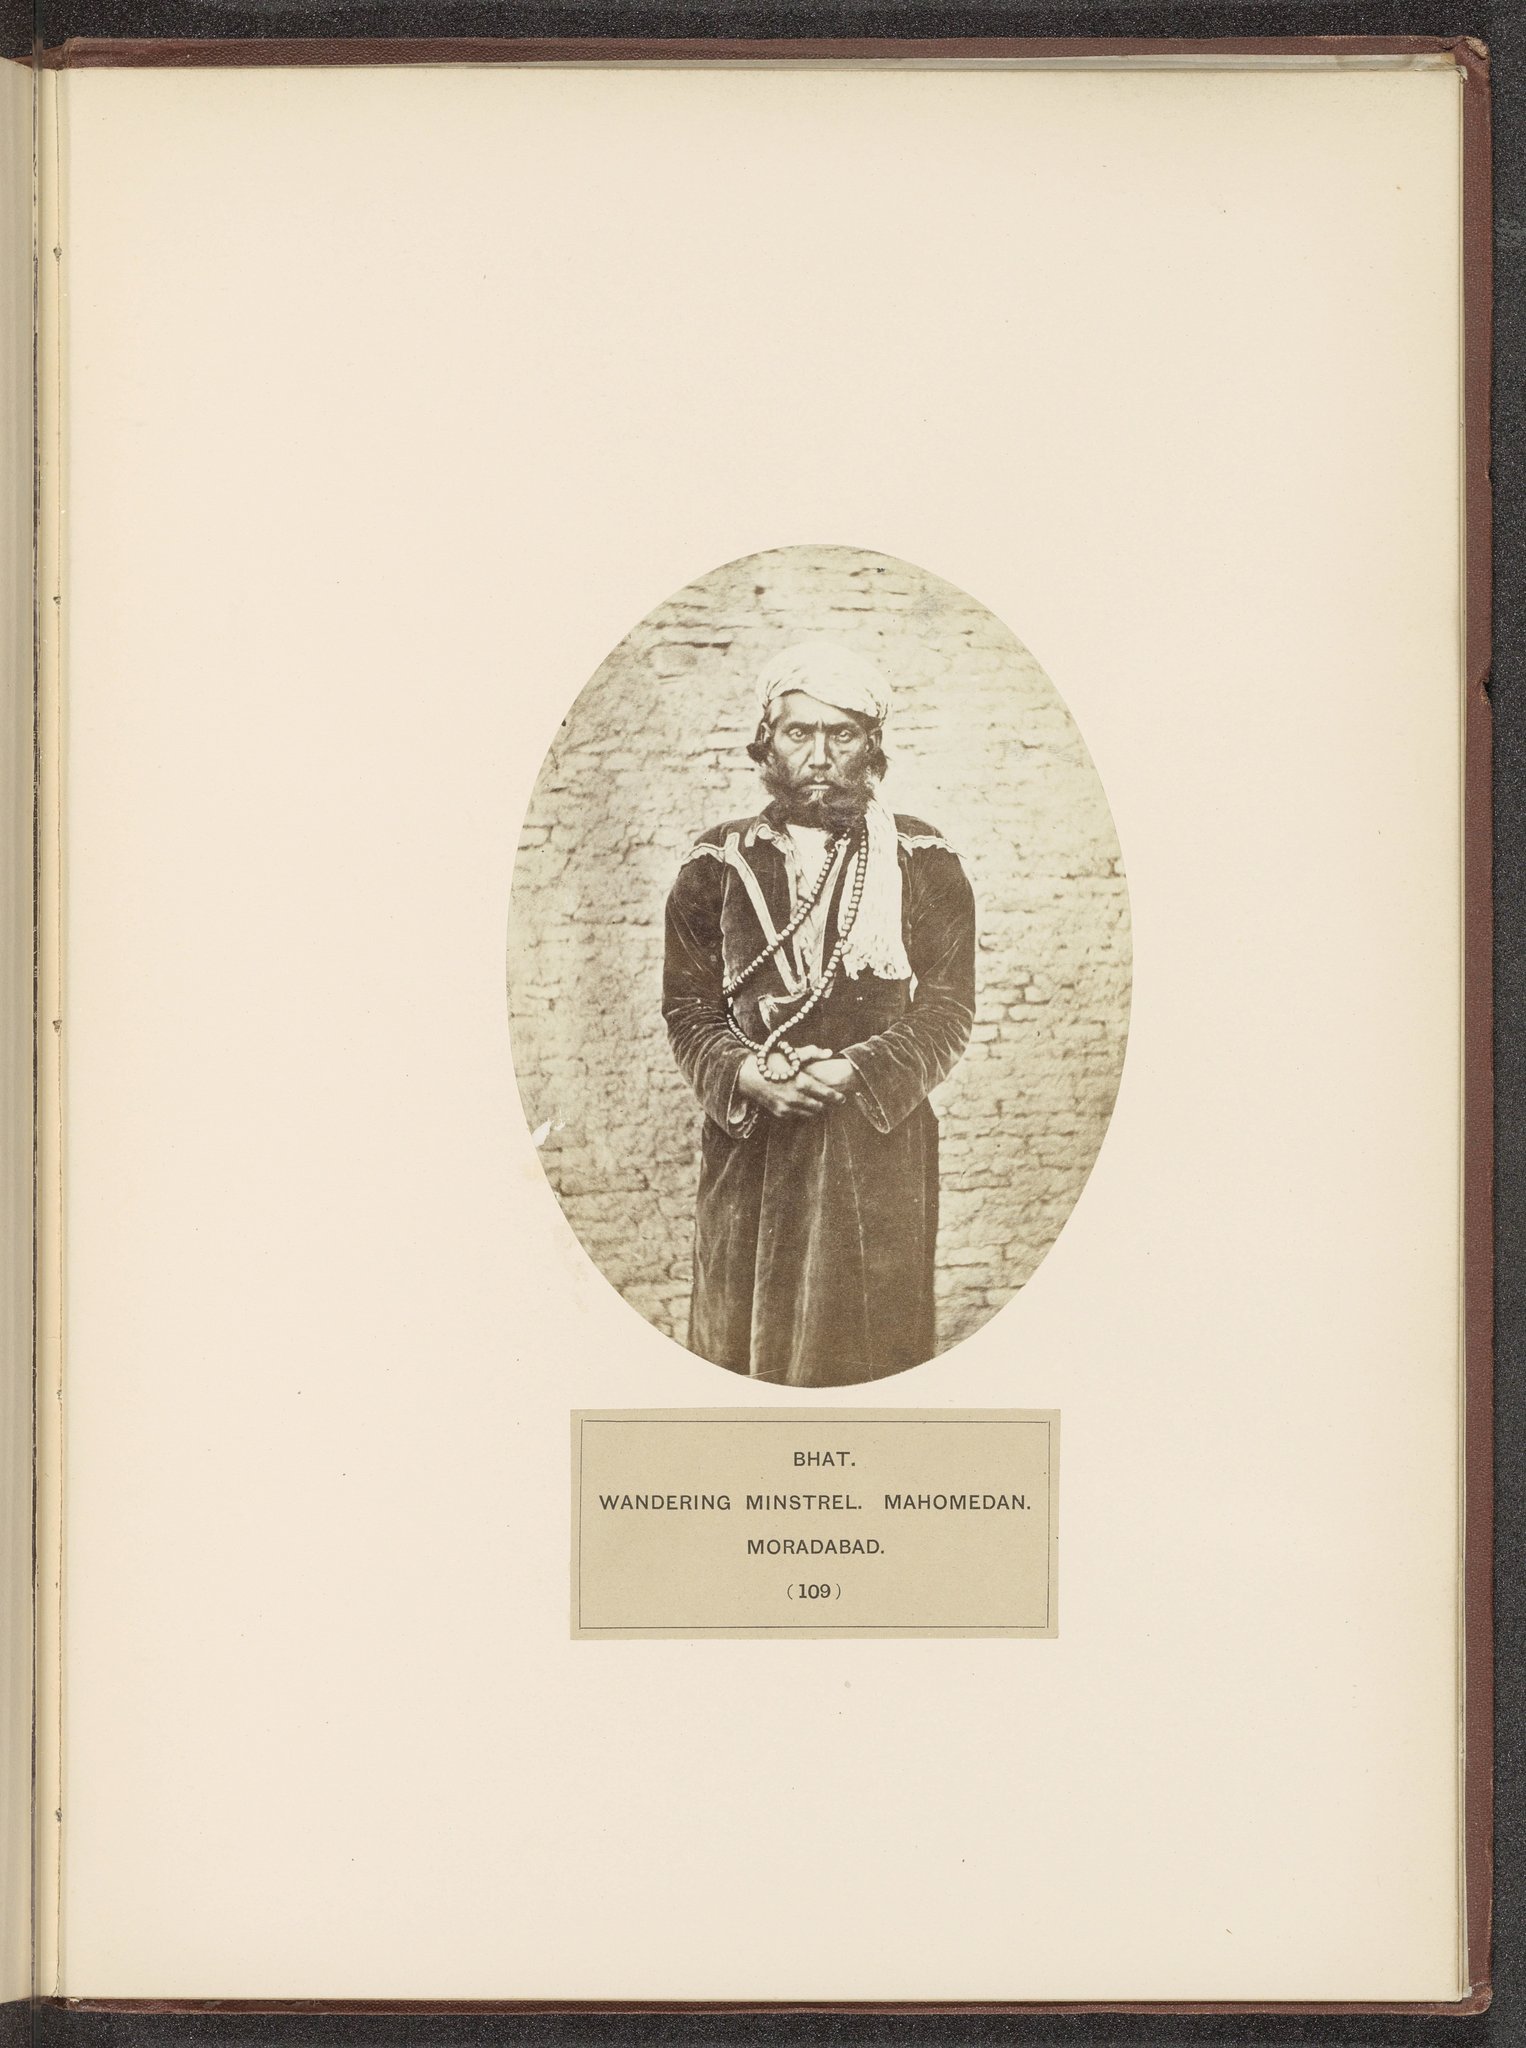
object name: photograph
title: Portrait of an unknown minstrel (Bhat) from Moradabad, Uttar Pradesh, India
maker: Anonymous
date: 1858-1868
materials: photographic support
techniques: albumen print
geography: moradabad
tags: minstrel, 'jongleur', human races; peoples; nationalities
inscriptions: number: ‘(109)’, inscription: ‘BHAT./ WANDERING MINSTREL. MAHOMEDAN./ MORADABAD.’